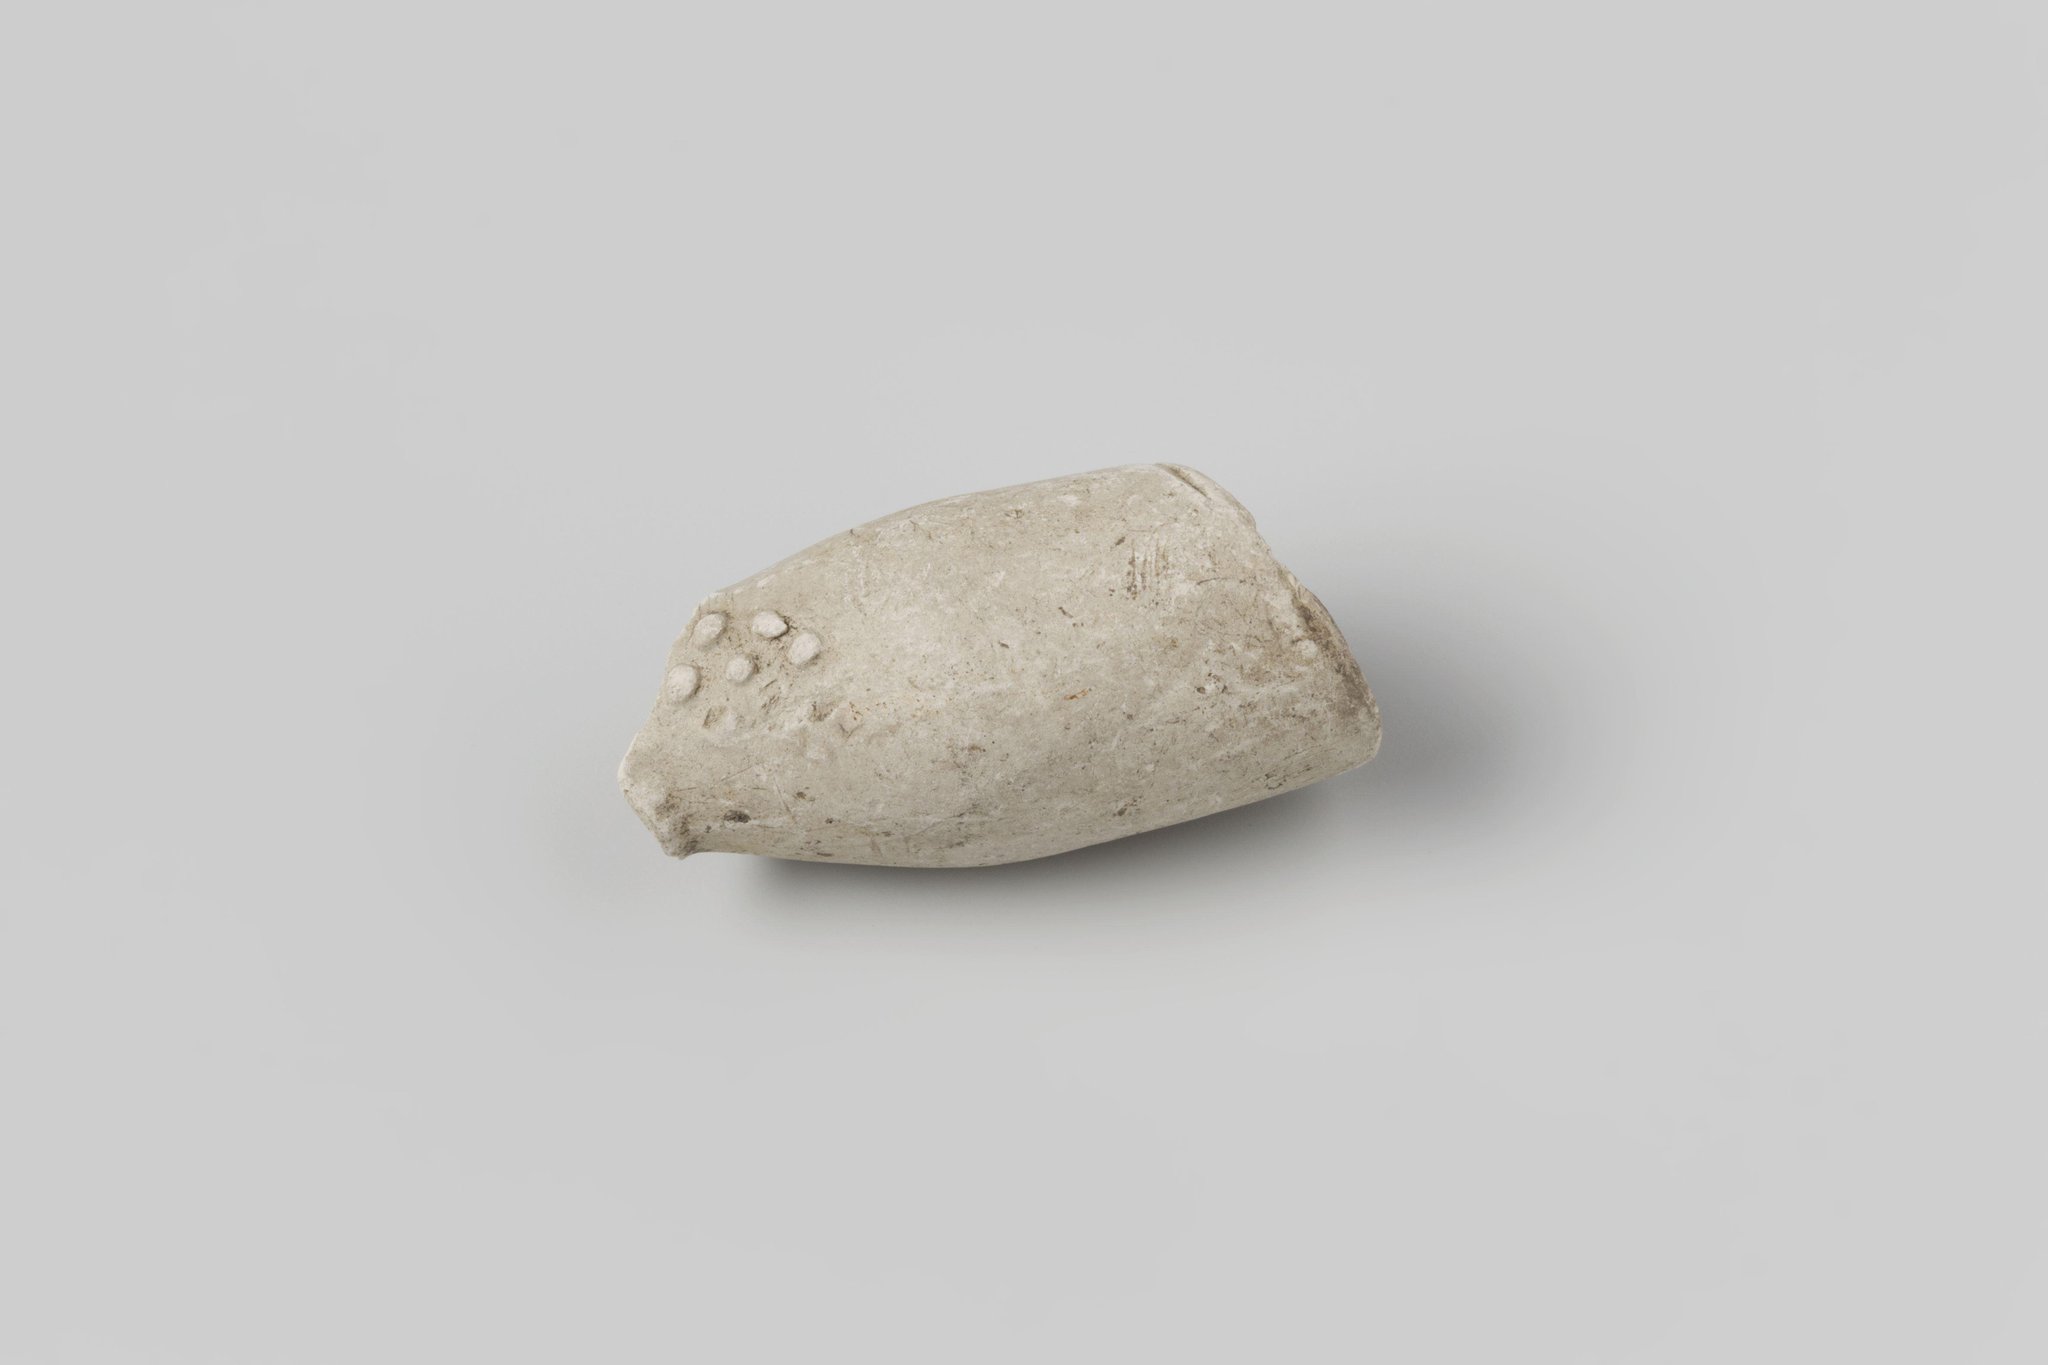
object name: fragment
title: Fragment pijpenkop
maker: Anonymous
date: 1600-1699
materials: clay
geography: netherlands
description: Fragment pijpenkop met twee gestippelde bloemen. Van de opgravingen op de Hofstede Arentsburg 1827-1831 onder toezicht van Professor Reuvens.